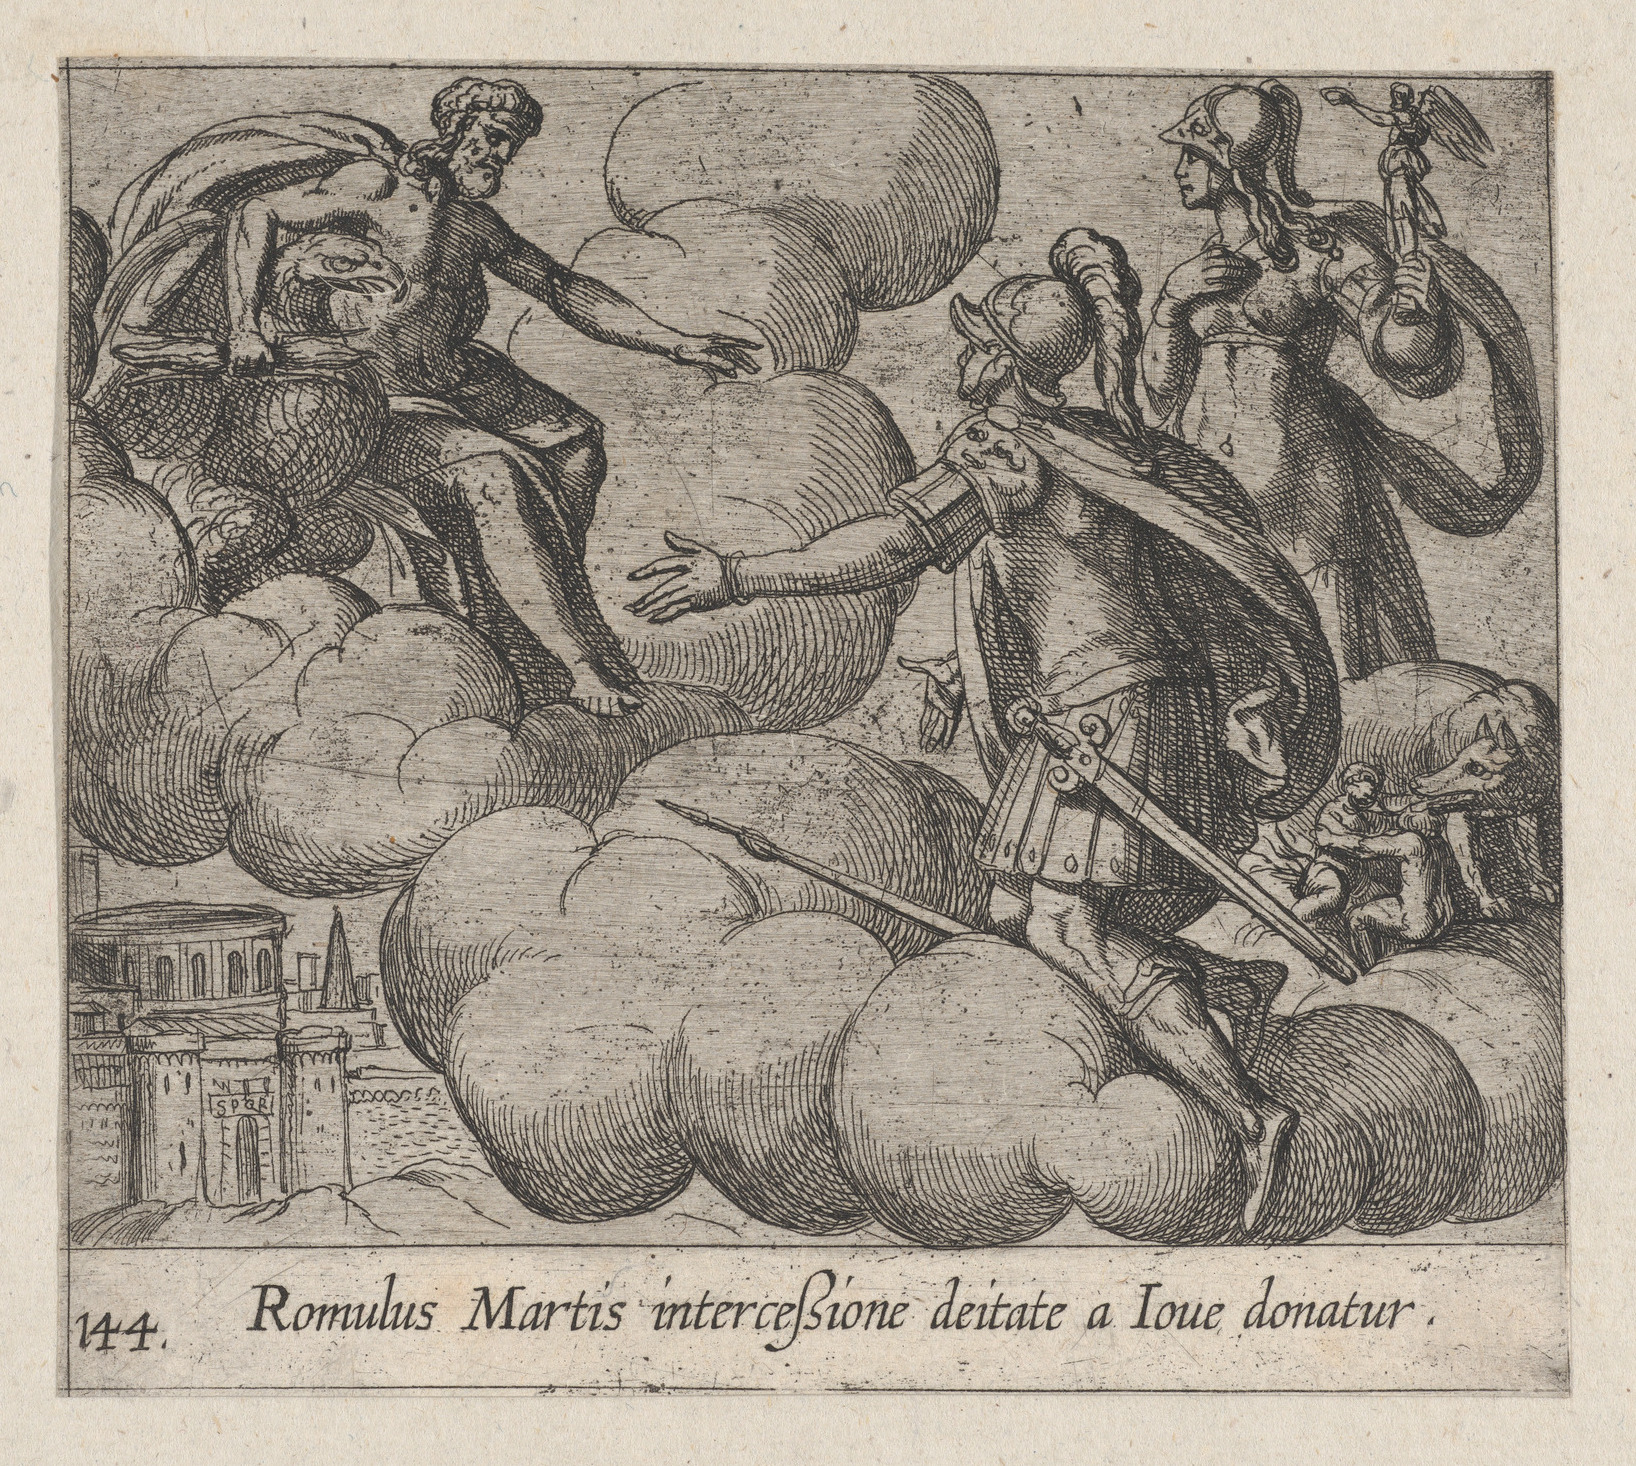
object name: print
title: Plate 144: The Immortalization of Romulus (Romulus Martis interceßione deitate a Ioue domatur), from Ovid's 'Metamorphoses'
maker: antonio tempesta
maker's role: artist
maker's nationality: italian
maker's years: 1555-1630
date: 1606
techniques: etching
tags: eagles,men